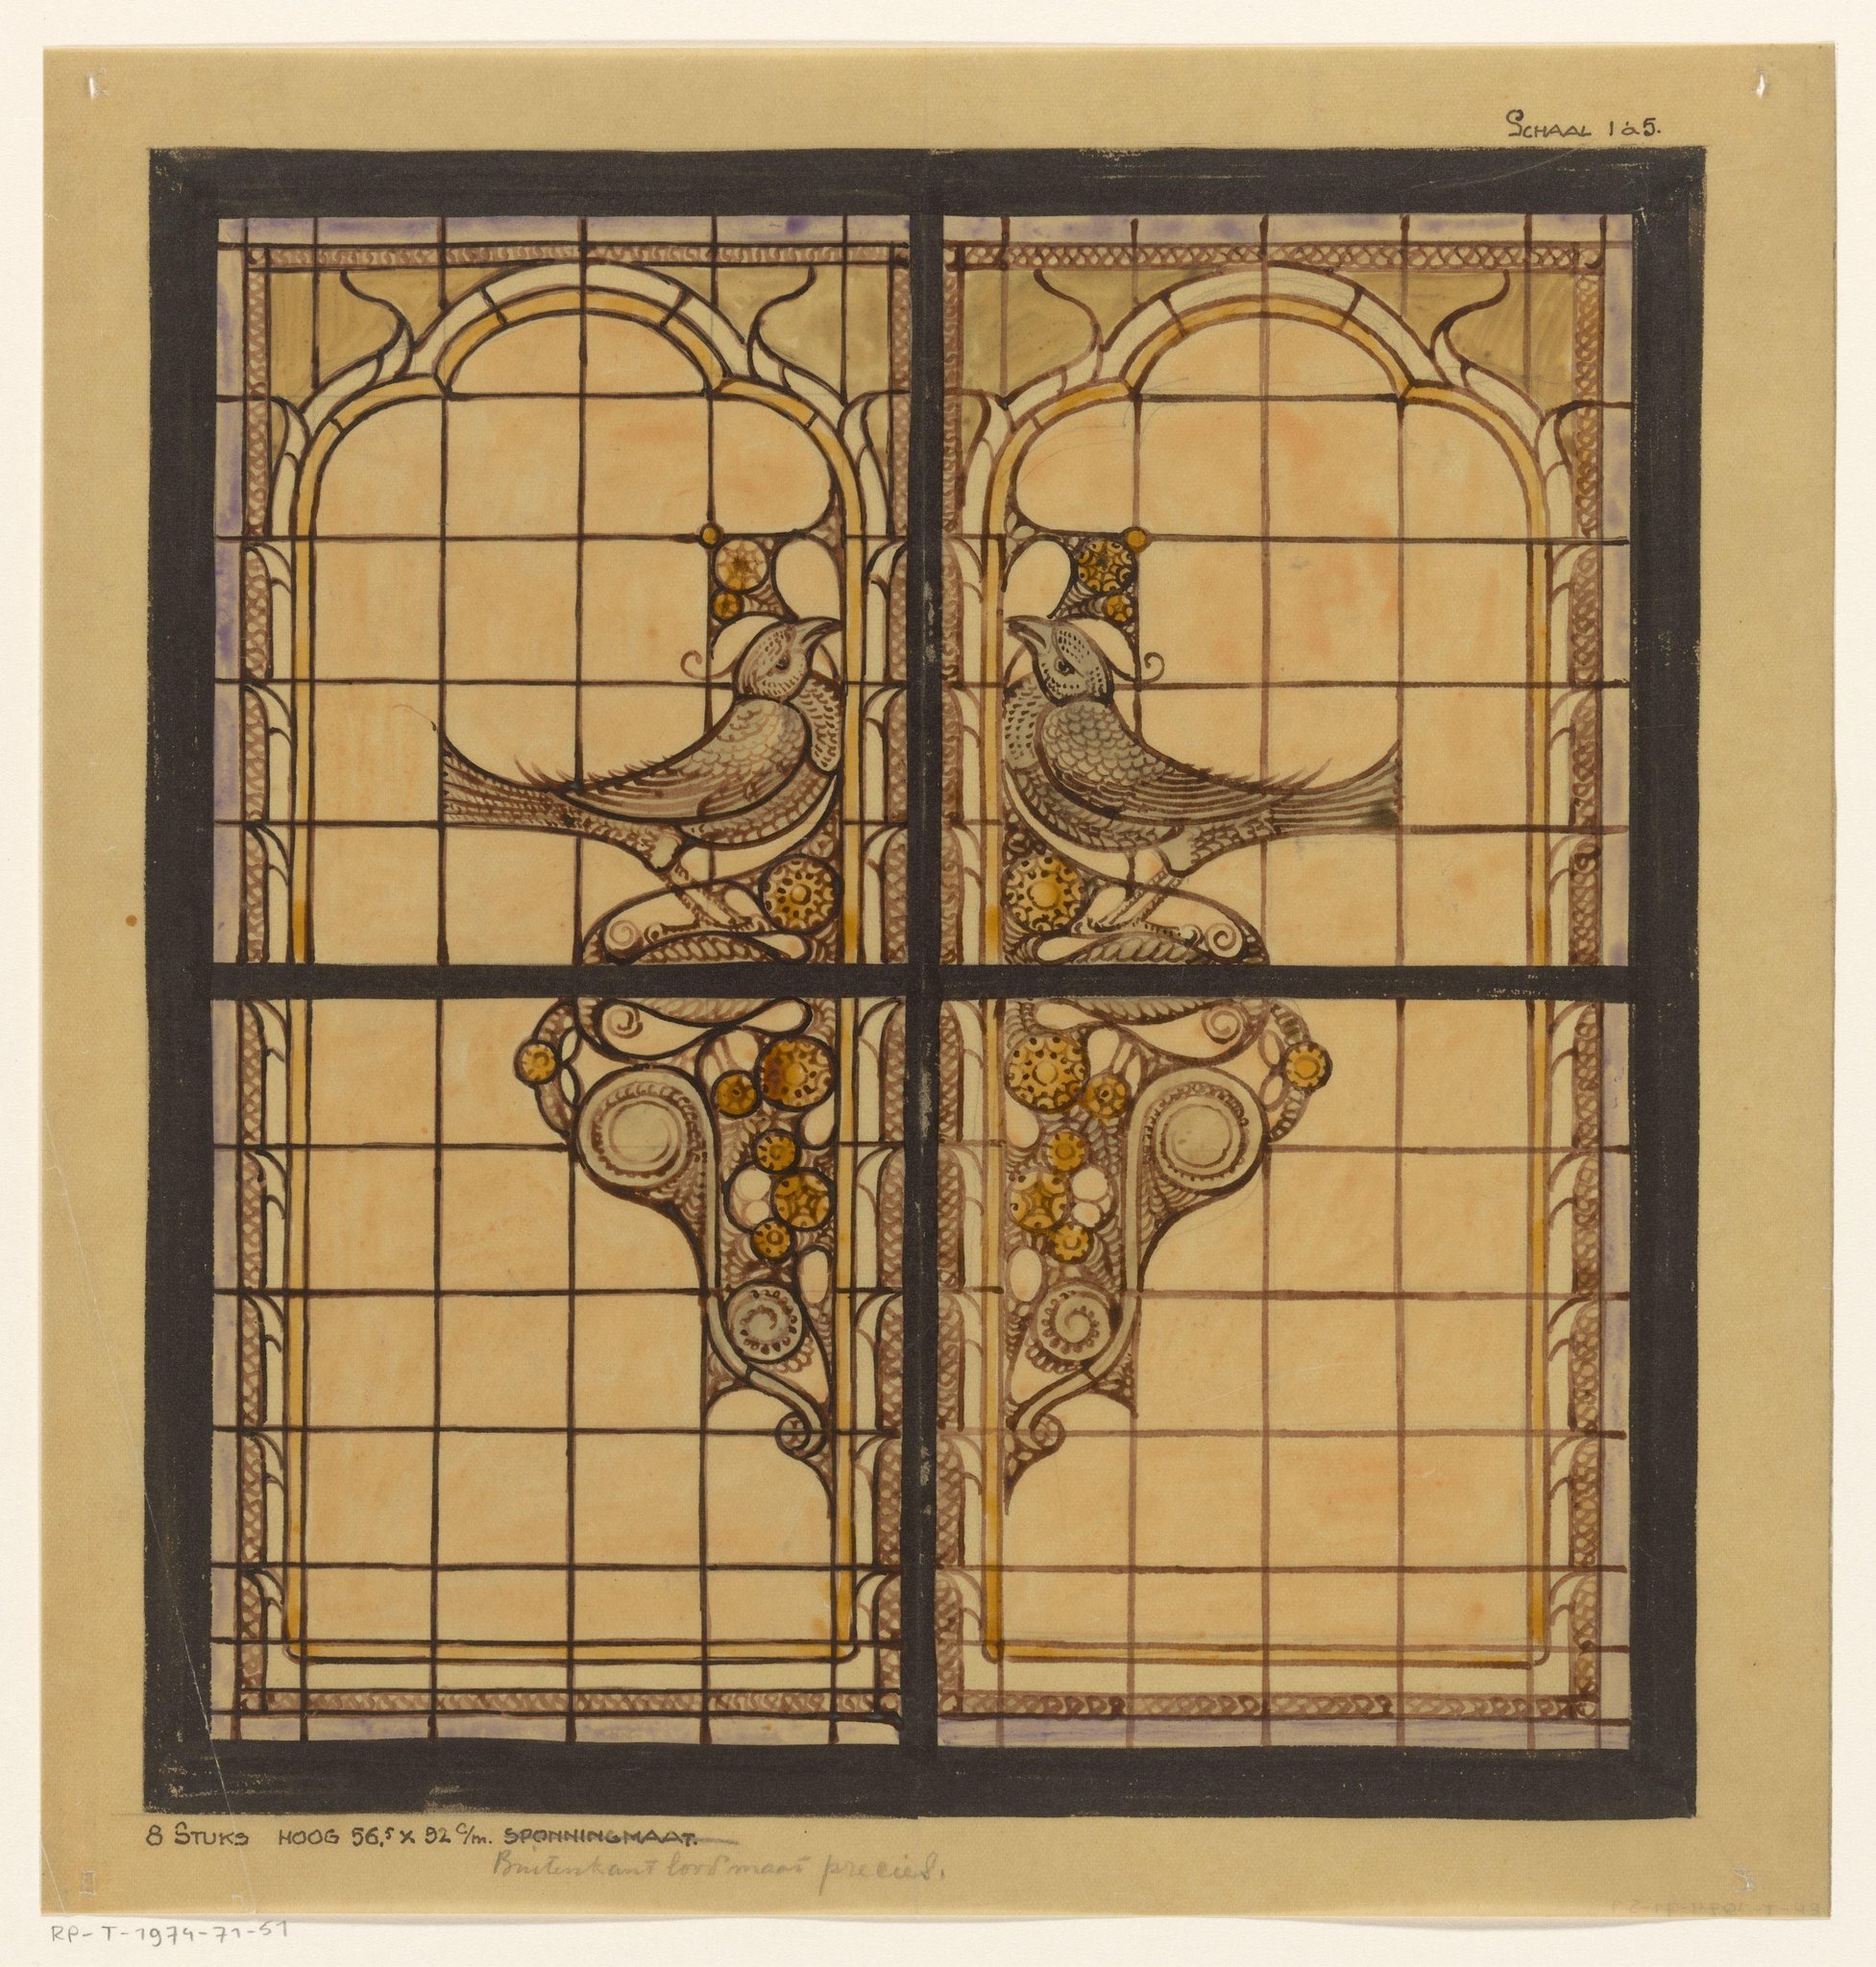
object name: drawing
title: Ontwerp voor een glas in loodraam met twee vogels en ornamenten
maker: Anonymous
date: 1907-1930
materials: ink, paint, pencil, paper, watercolor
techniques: brush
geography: amsterdam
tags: ornaments ~ art, birds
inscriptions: inscription: ‘Schaal 1 a 5./ 8 stuks hoog 56,5 x 92 cm/ Buitenkant lood maat precies.’, collector's mark: ‘R:MVS’